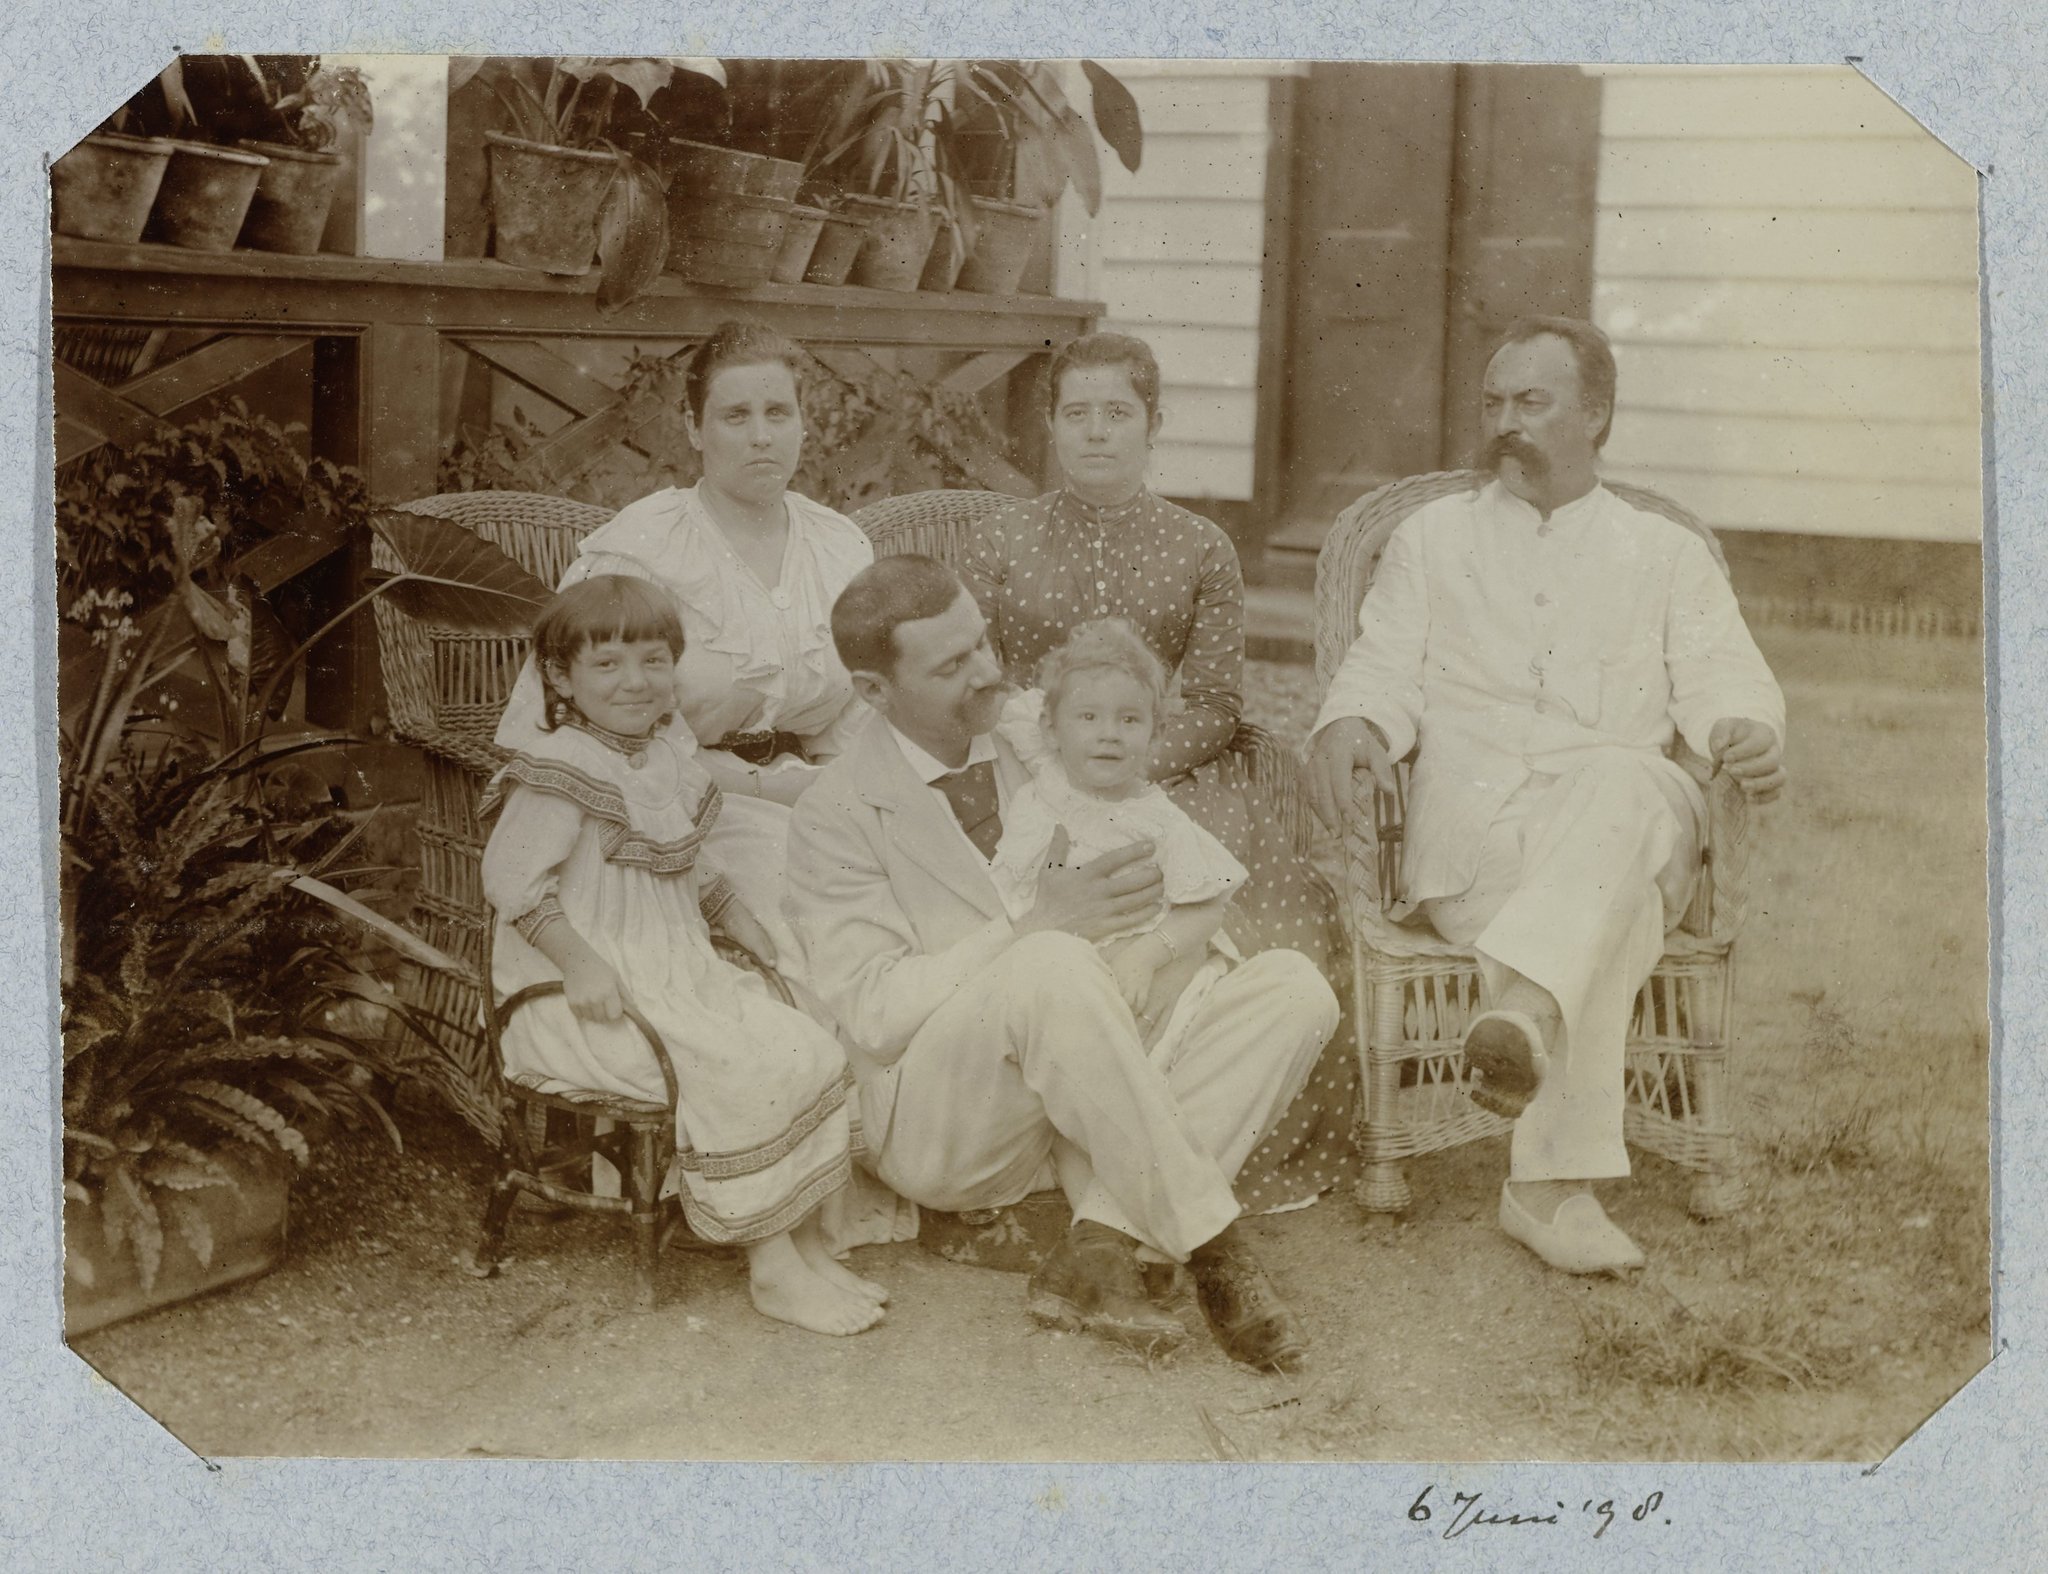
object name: photograph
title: Groepsportret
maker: théodore van lelyveld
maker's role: painter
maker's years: 1867-1954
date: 1898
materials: photographic support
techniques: collodion silver print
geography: suriname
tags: nijmegen, the hague, théodore van lelyveld, family group, especially parents with their child(ren), suriname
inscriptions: inscription: ‘6 Juni '98.’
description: Groepsportret van de familie Van Lelyveld en de familie Van Oosteren, 6 juni 1898. Centraal Théodore van Lelyveld met echtgenote Dolly en dochter Roosje. Fotoafdruk in een fotoalbum van Théodore van Lelyveld over Suriname uit 1895-1898.